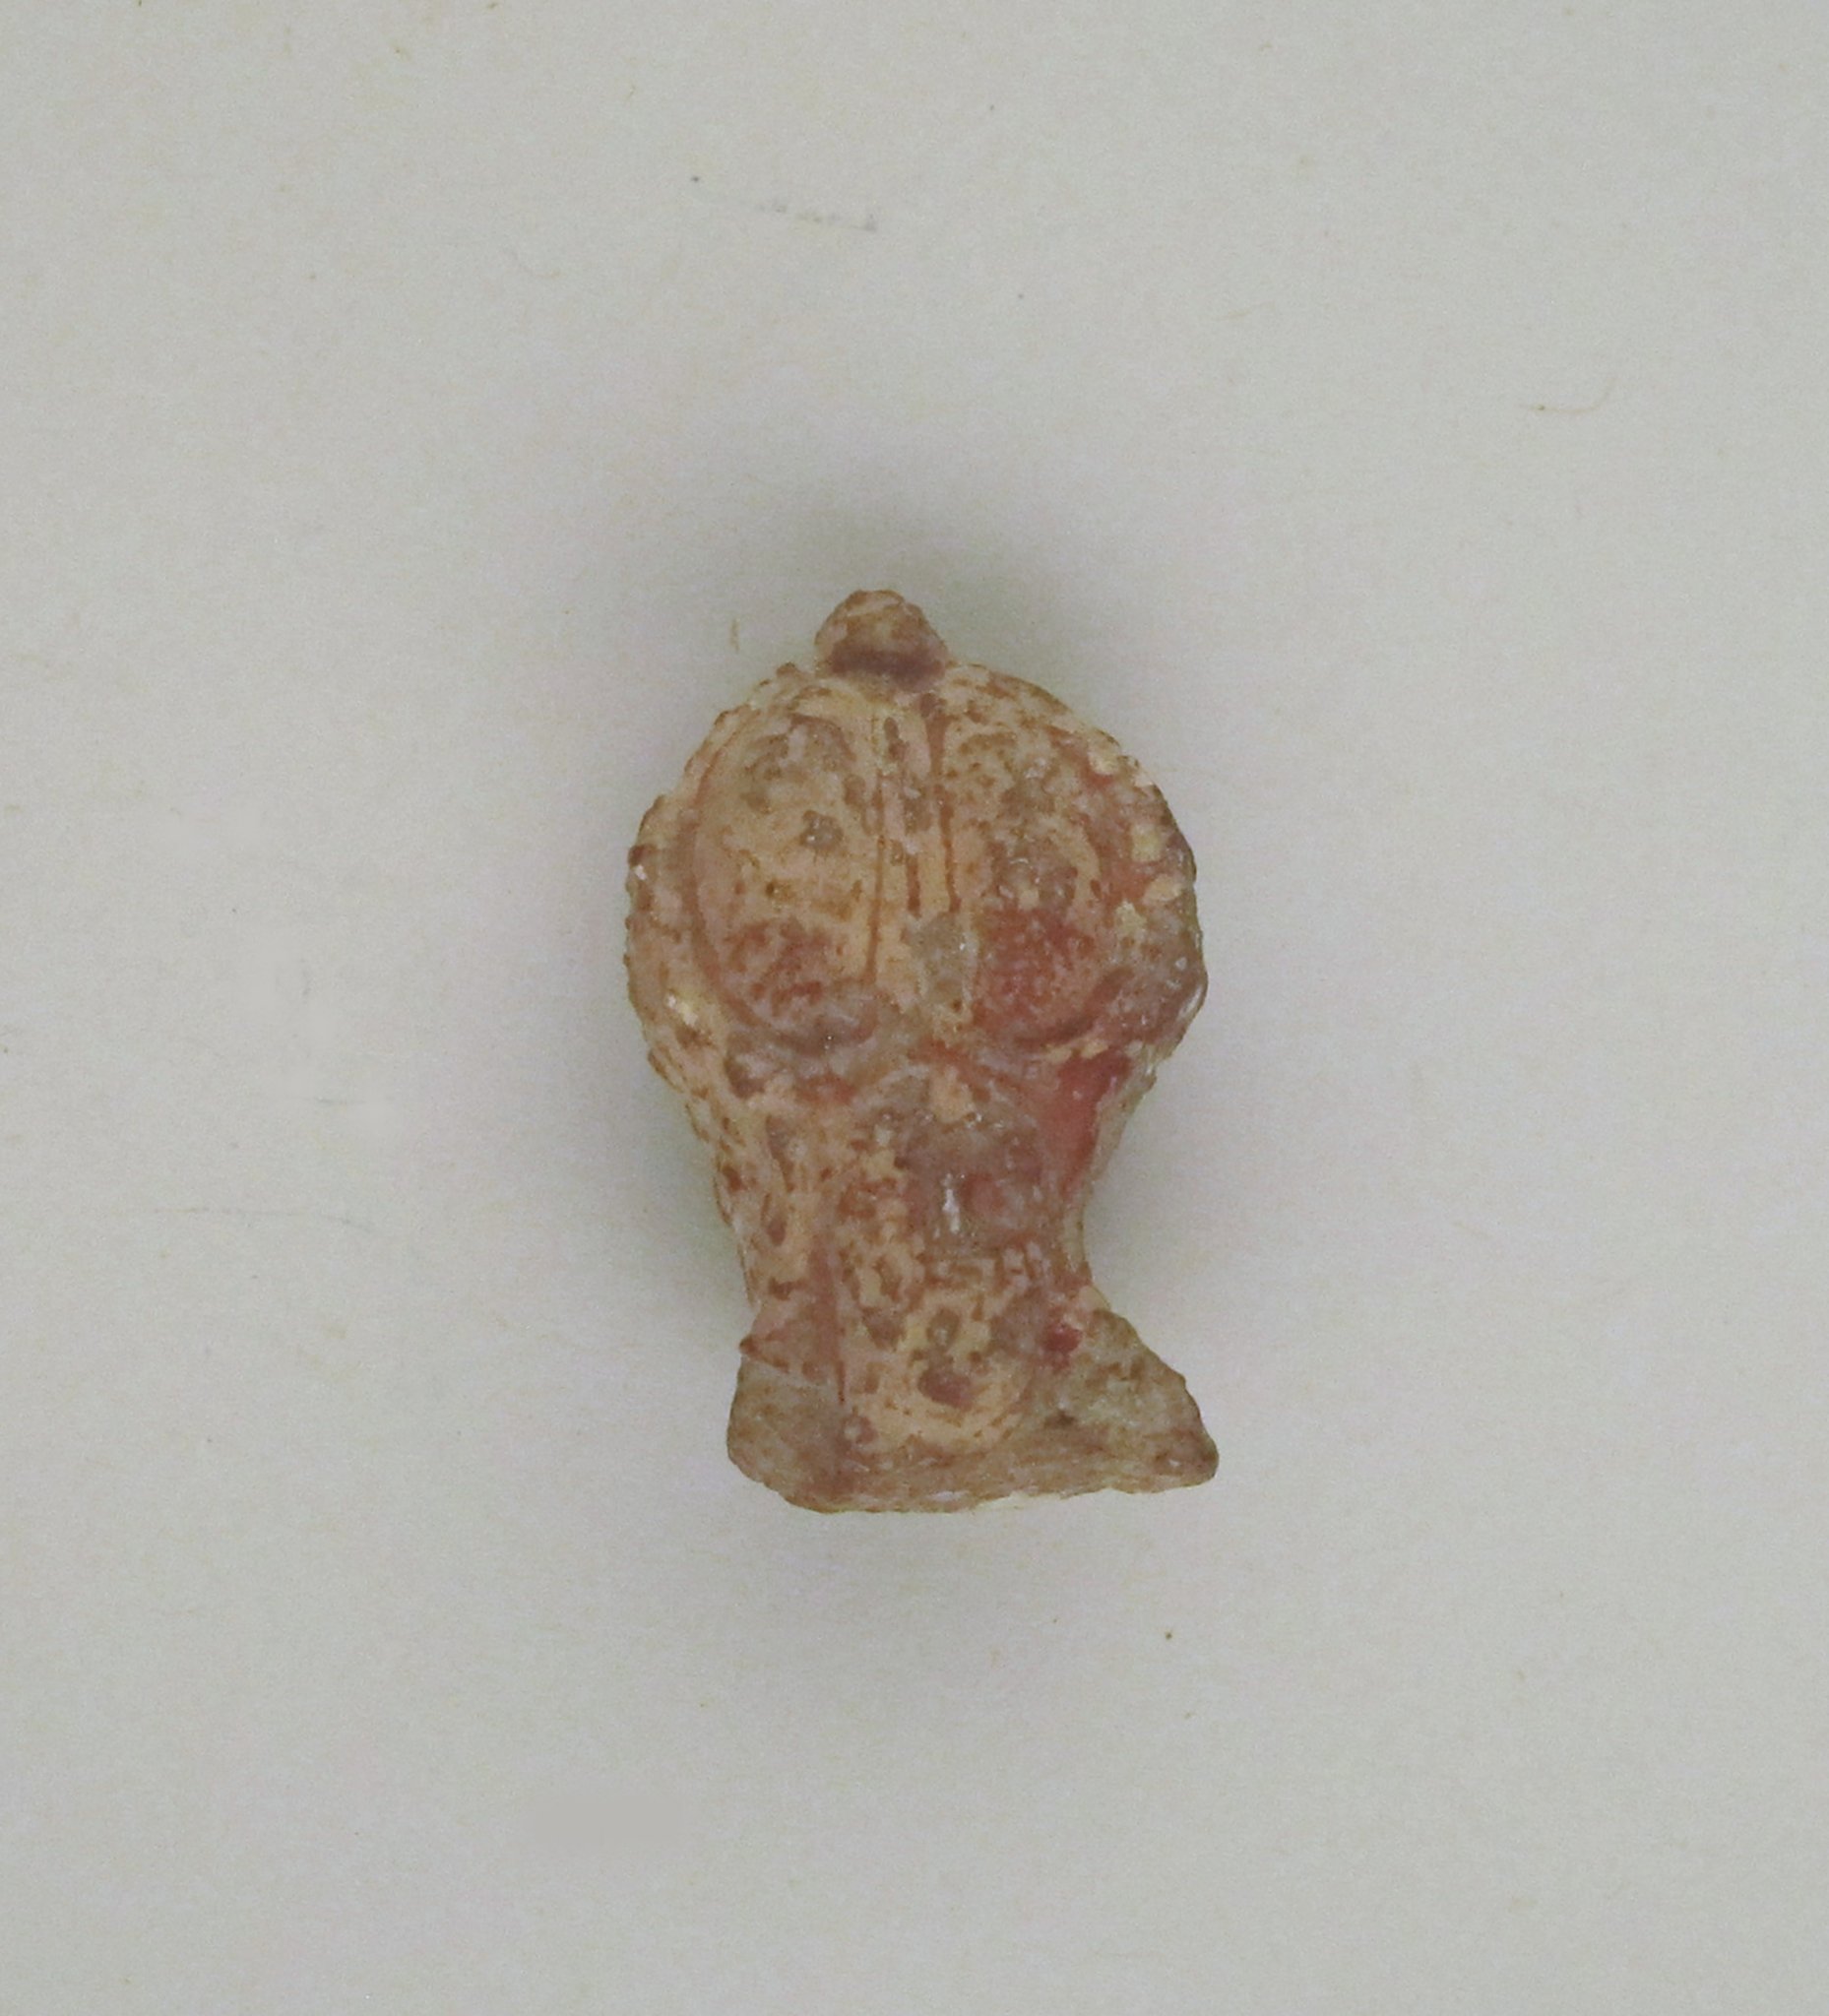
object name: cup with handle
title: Cup handle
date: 7000 BCE-330 CE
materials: terracotta